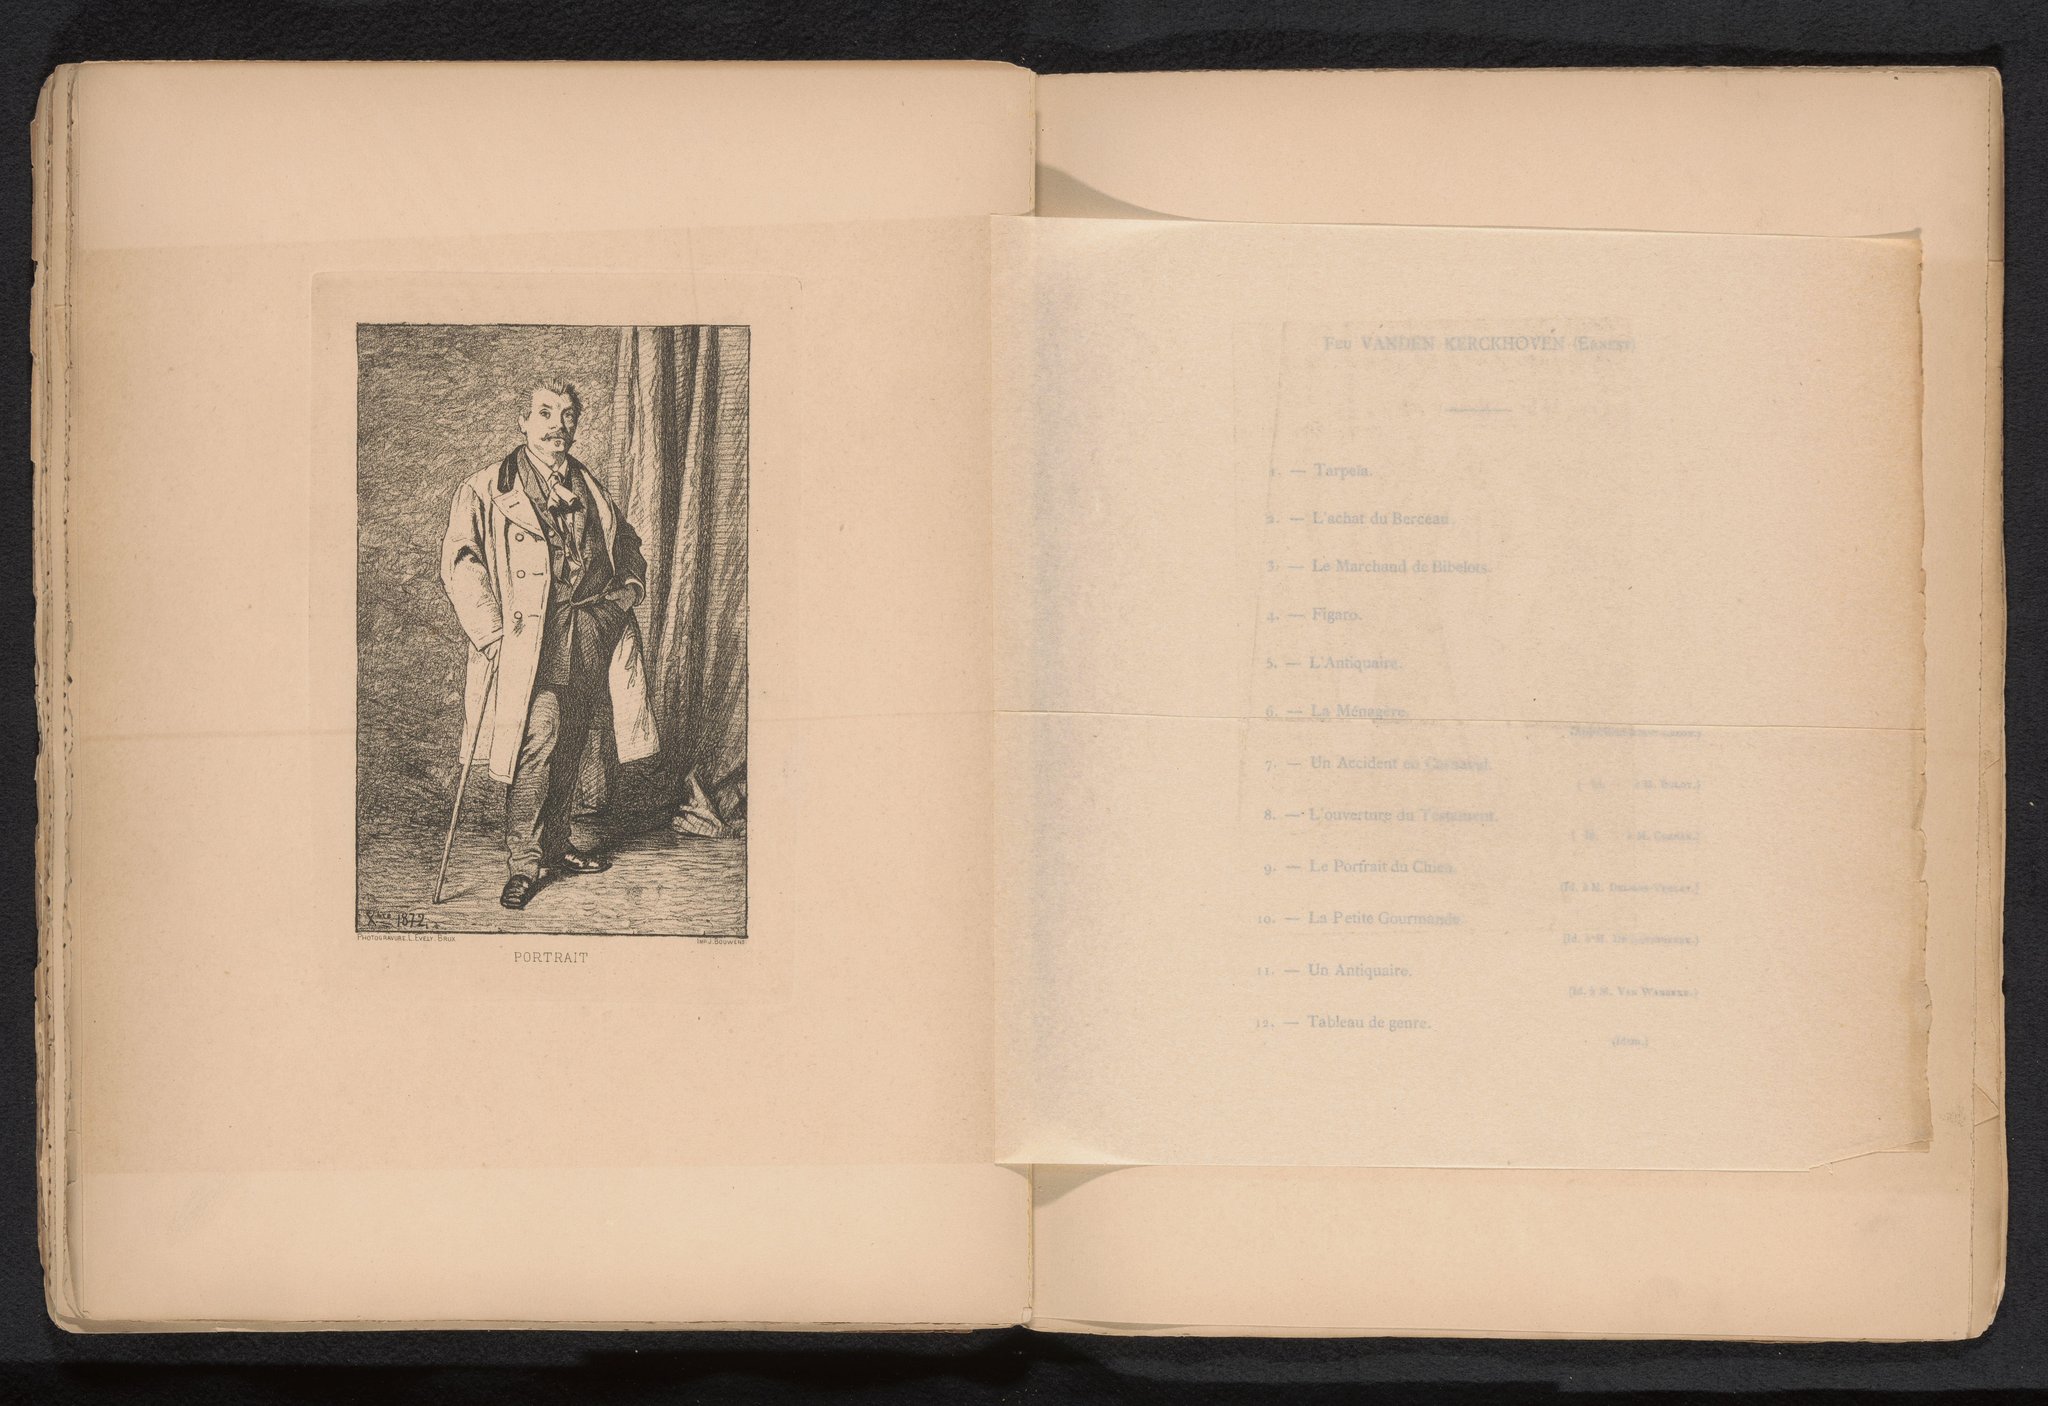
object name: reproduction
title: Reproductie van een tekening van een portret van een onbekende man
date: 1878-1883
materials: paper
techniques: photoaquatint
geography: brussels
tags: historical persons not known by name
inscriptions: signature: ‘Xbre 1872.’